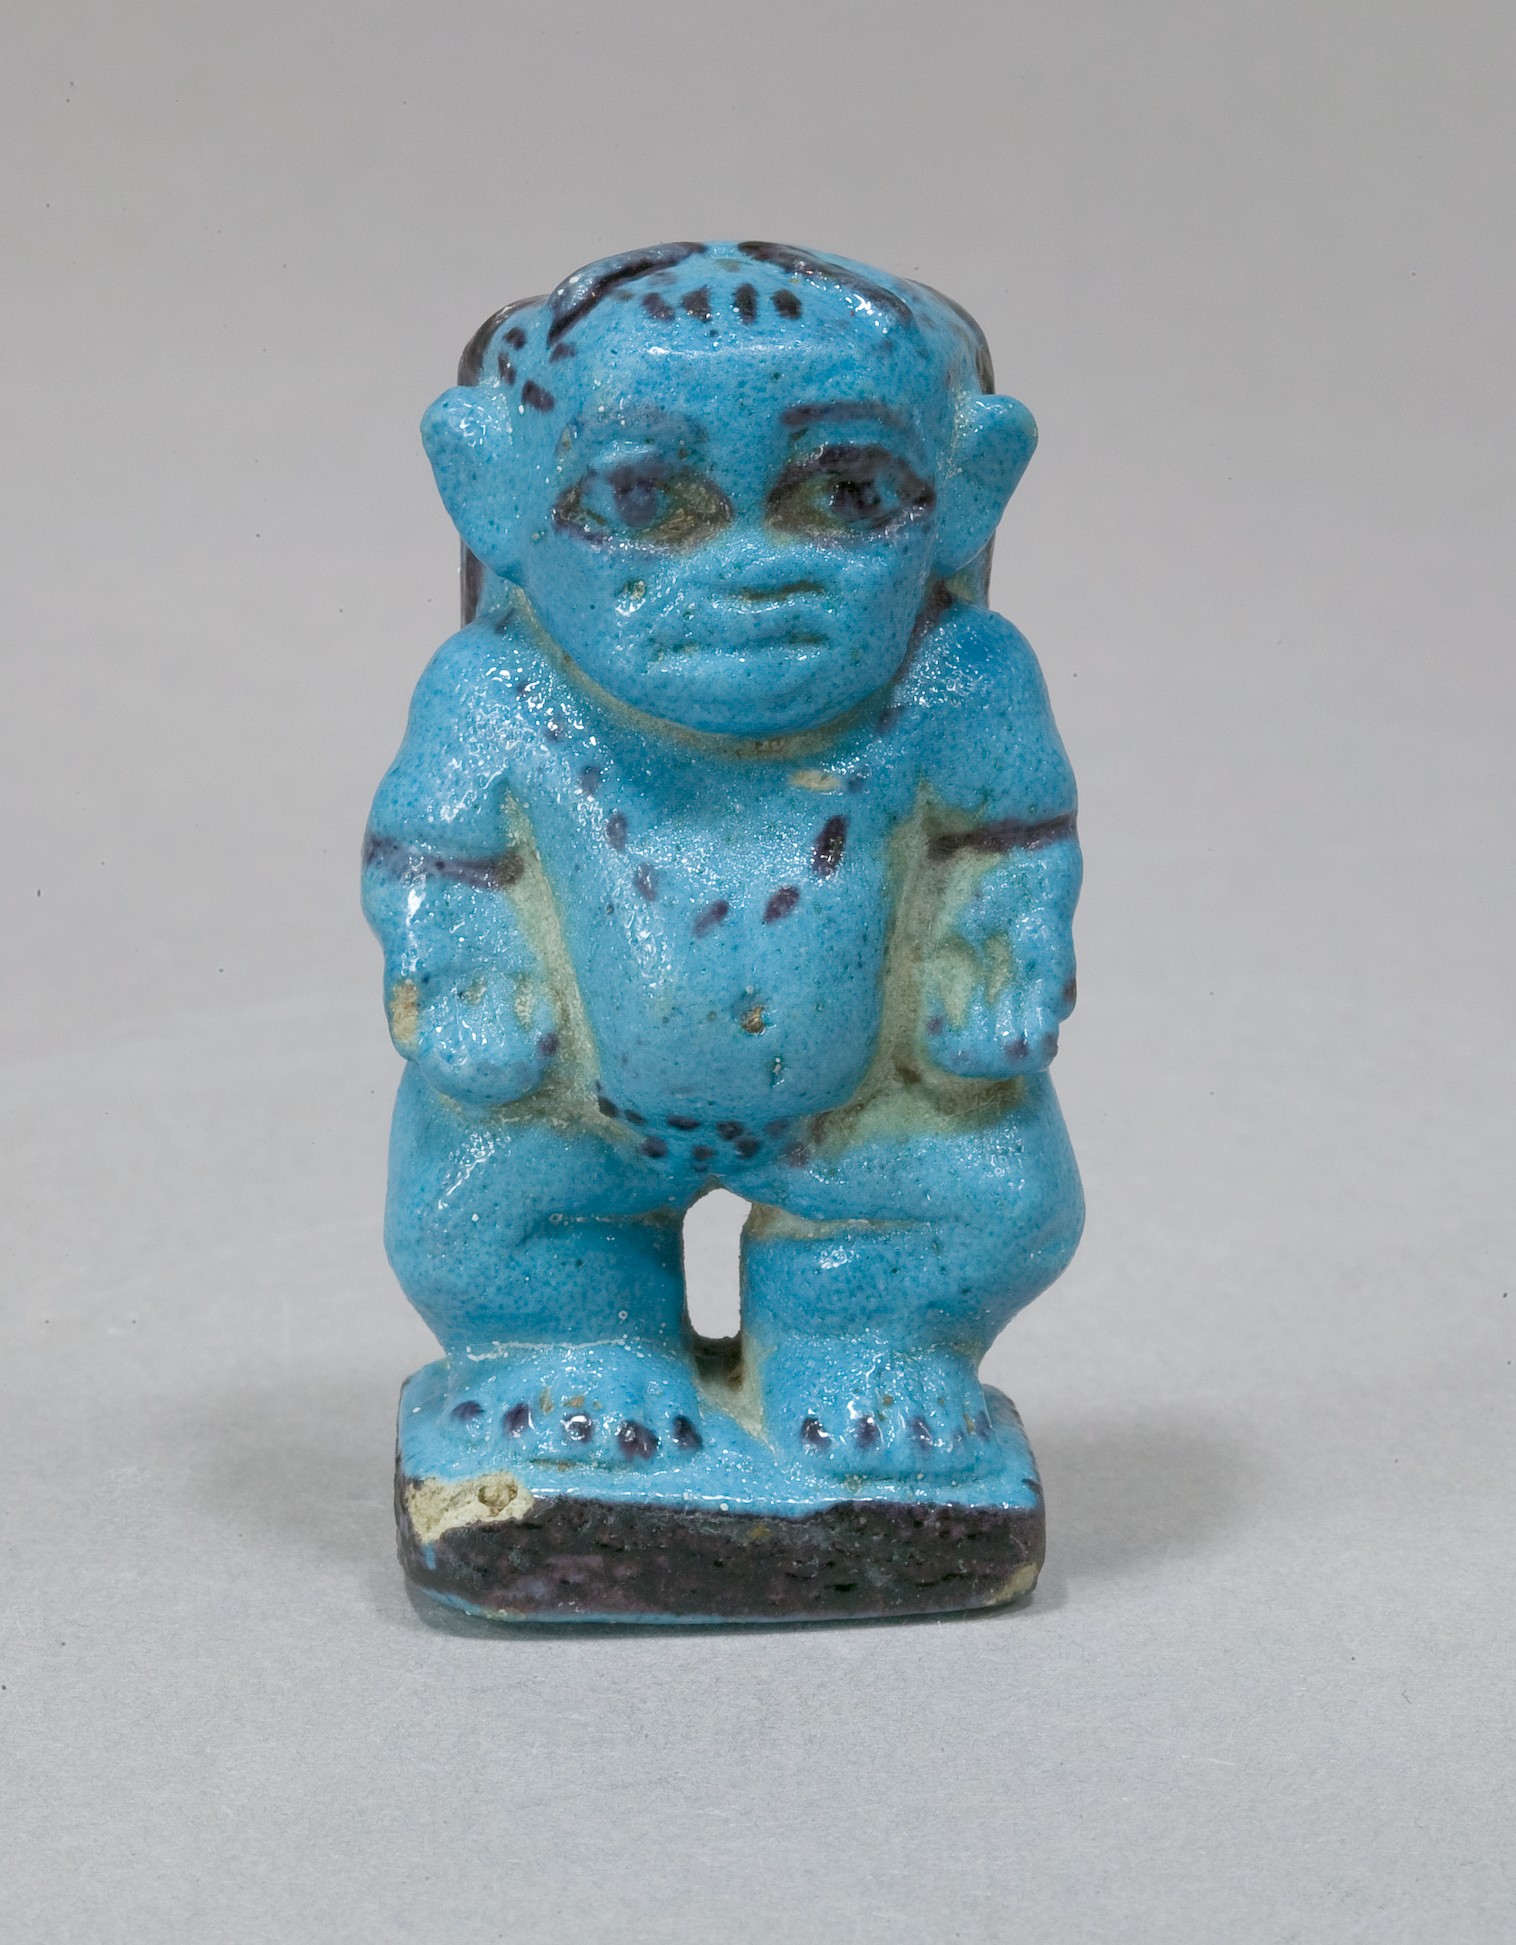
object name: statuette, dwarf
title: Figure of a Female Dwarf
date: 1981-1640 BCE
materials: faience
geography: egypt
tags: women